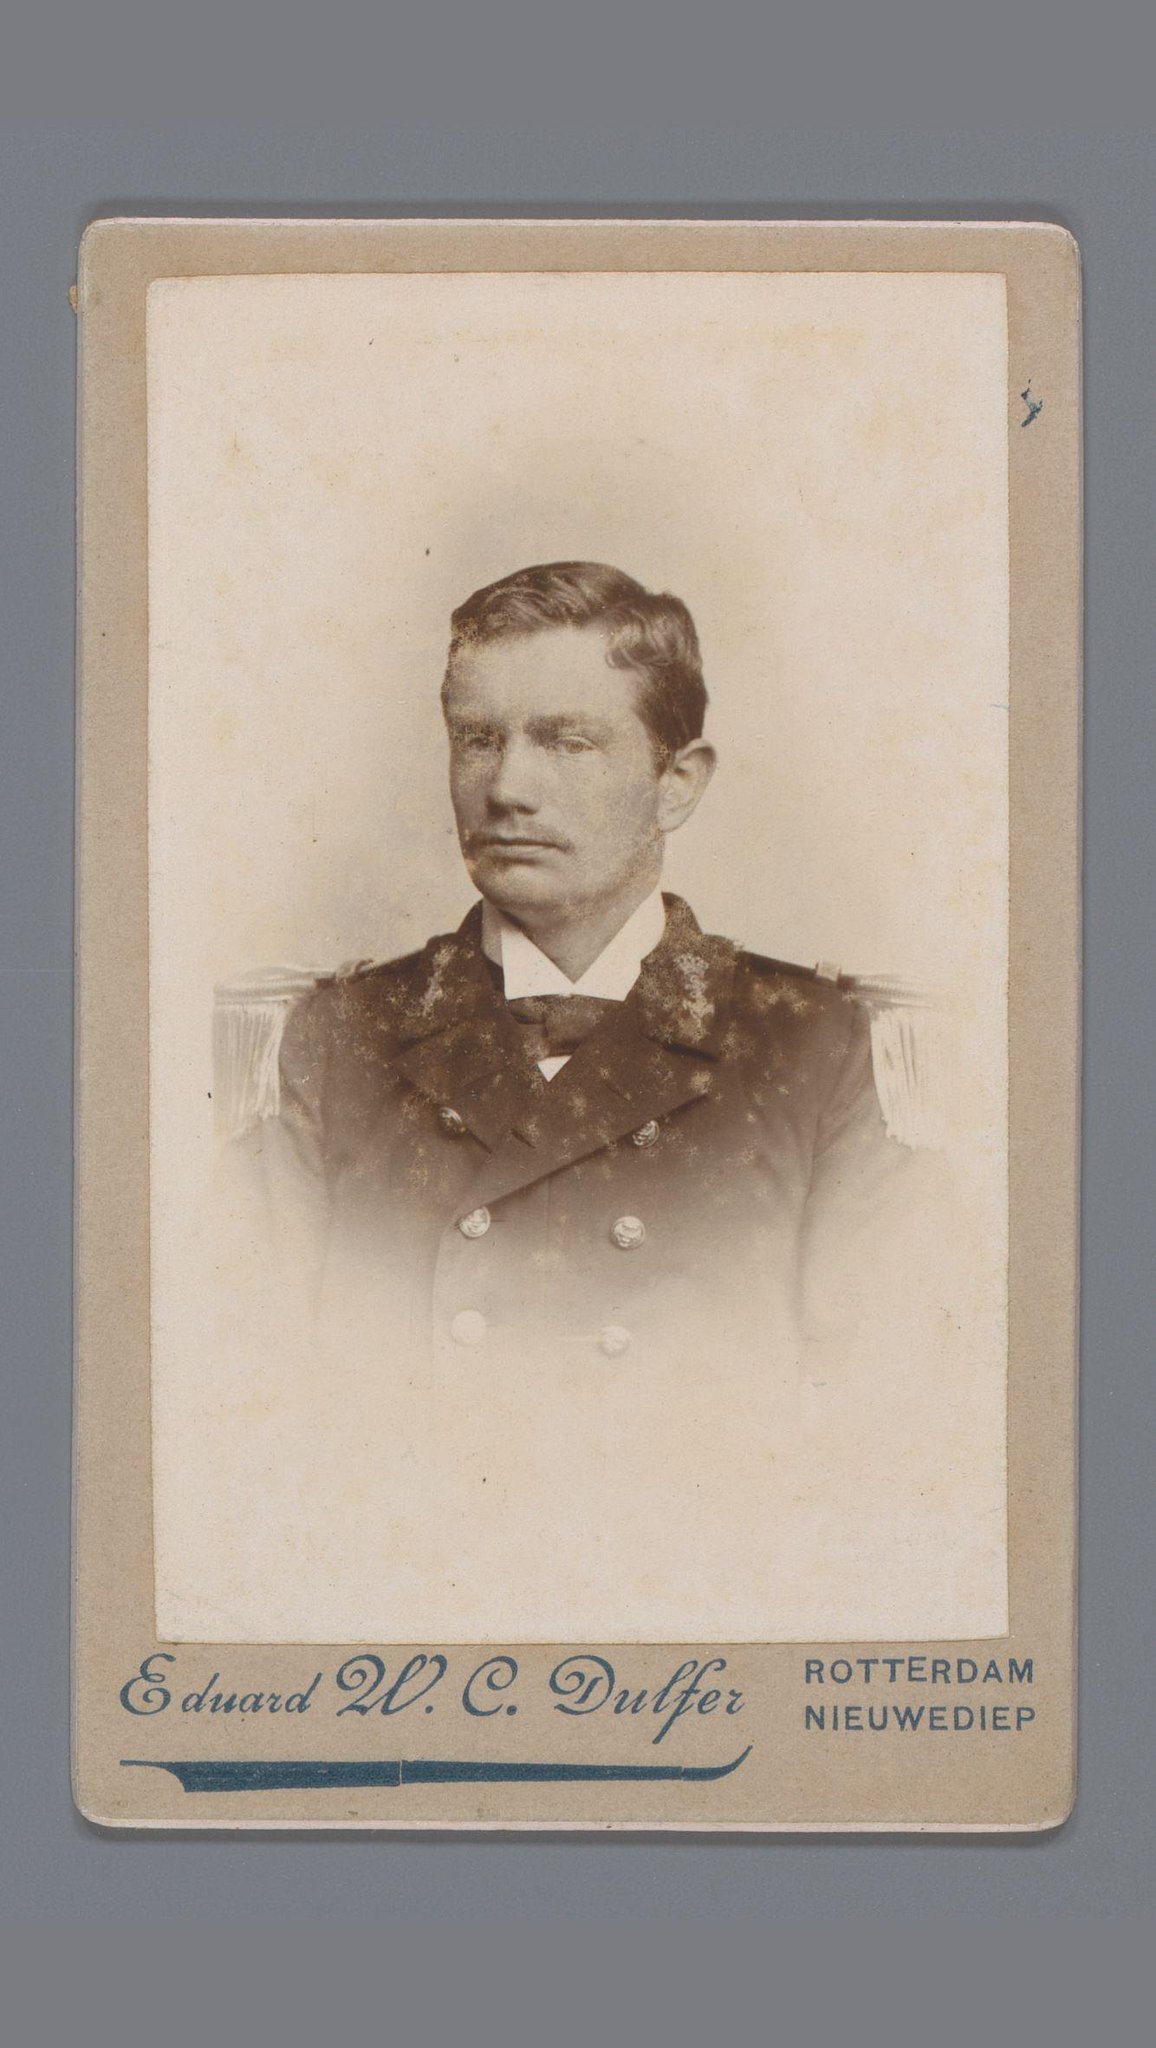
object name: photograph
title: Portret van een onbekende man in uniform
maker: willem eduard coenraad dulfer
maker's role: fotograaf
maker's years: 1860-1920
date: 1895-1906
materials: paper, cardboard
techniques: collodion silver print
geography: rotterdam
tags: adult man, anonymous historical person portrayed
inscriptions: inscription: ‘VERGROOTINGEN NAAR EEN PORTRET./ De plaat blijft voor nabestelling bewaard.’, address: ‘Nieuwediep,/ Hoofdgracht 53./ Rotterdam,/ Aert van Nesstraat 77.’